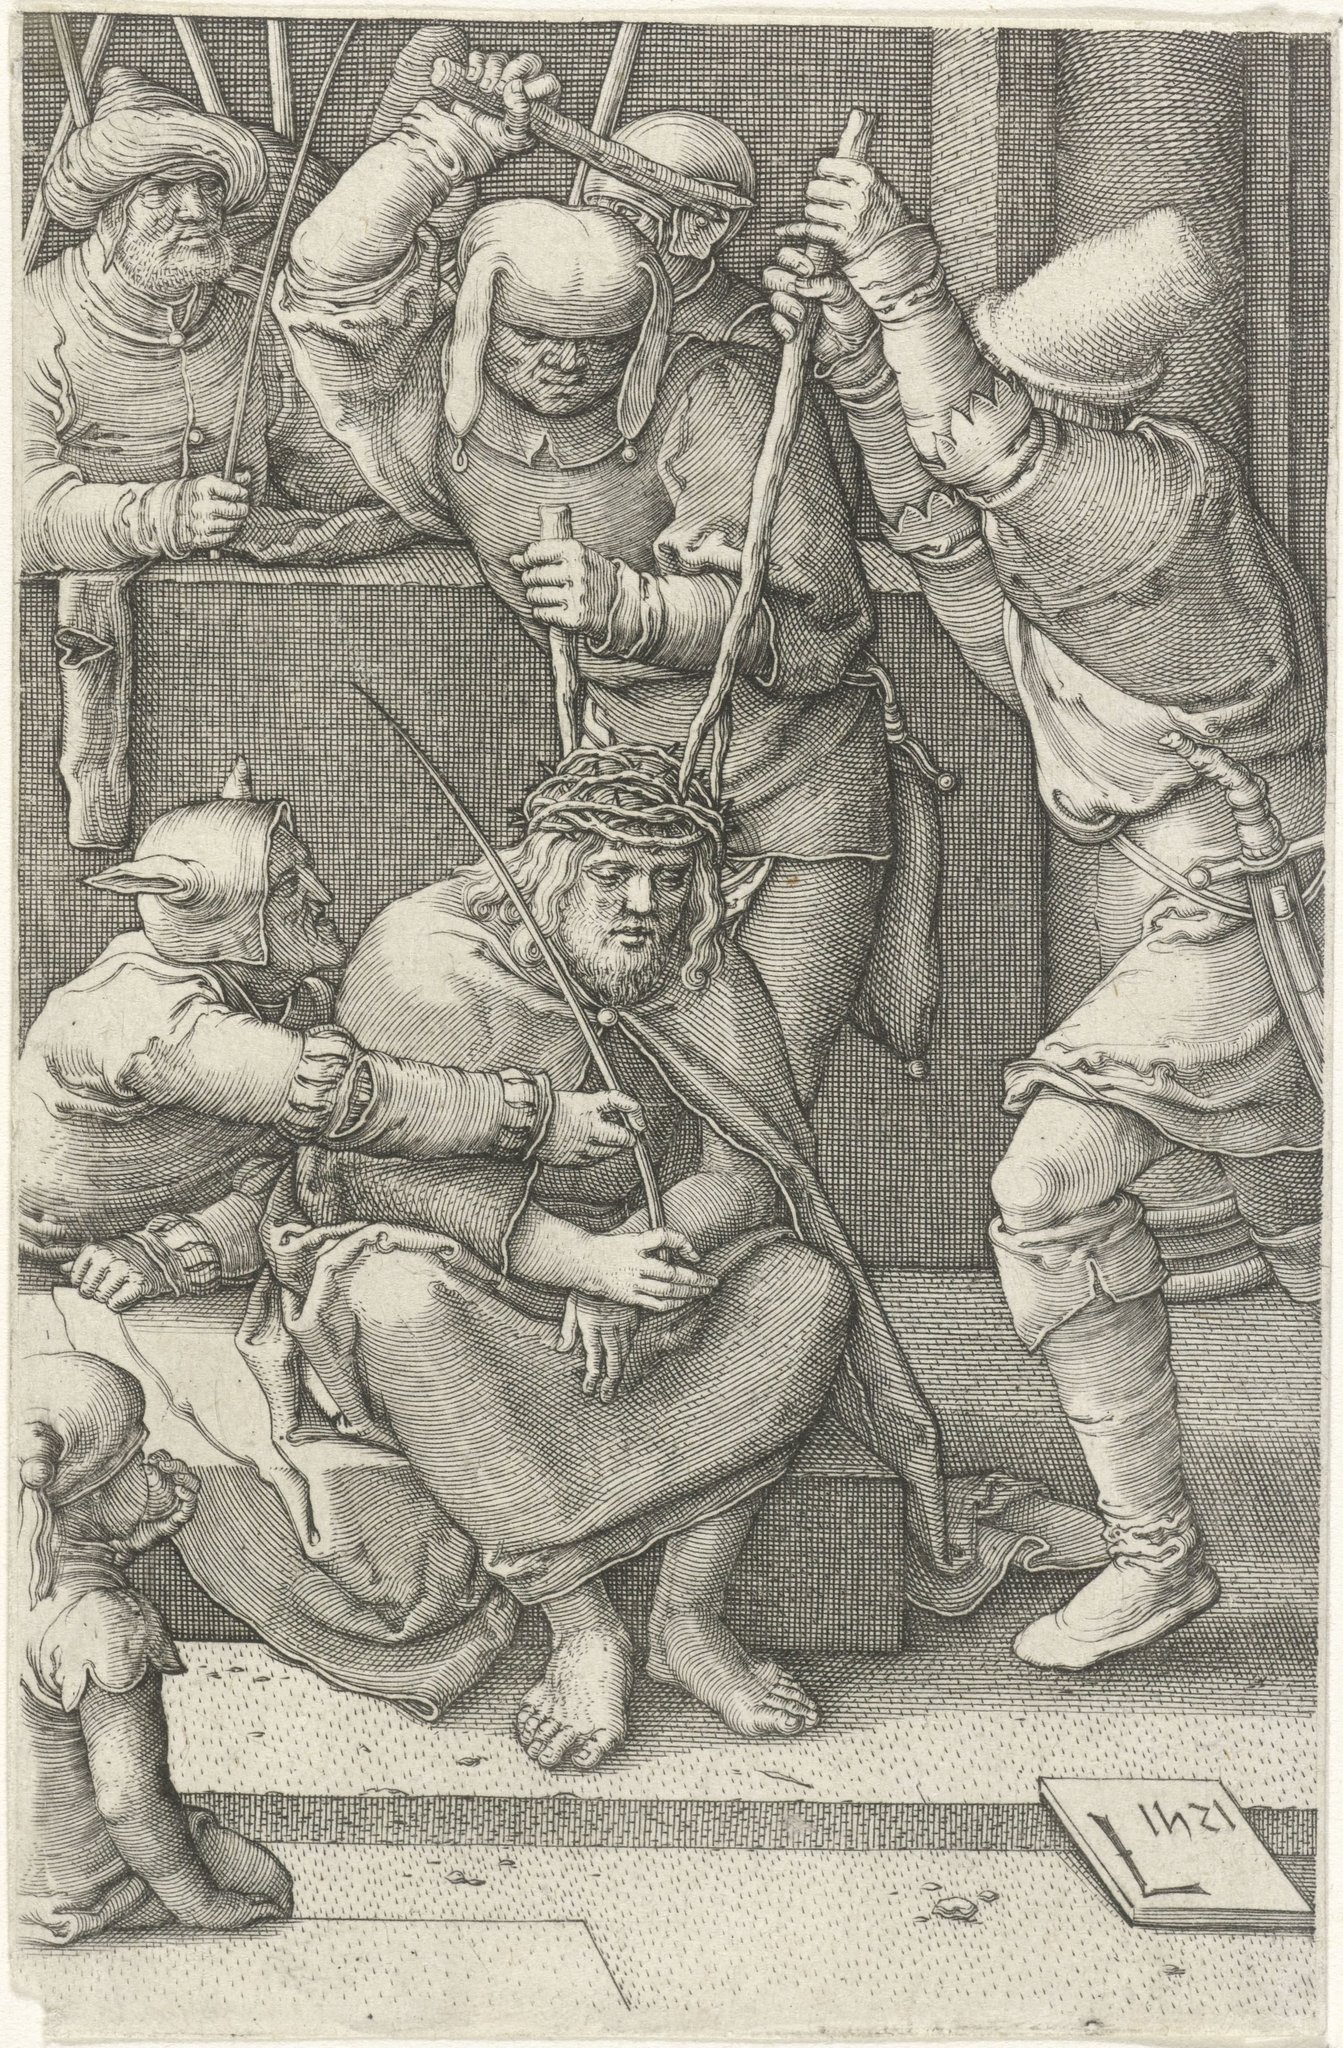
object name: print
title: Passie van Christus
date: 1613-1622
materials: paper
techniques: engraving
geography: amsterdam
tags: the crowning with thorns: soldiers with sticks place a thorny crown on christ's head and give him a reed (matthew 27:27-31; mark 15:16-20; john 19:2-3)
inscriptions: collector's mark: Lugt 2542, collector's mark: Lugt 2228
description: Beulen zetten Christus een doornenkroon op het hoofd en geven hem een rietstok in de hand. Op de achtergrond staat een man klaar om Christus te slaan.